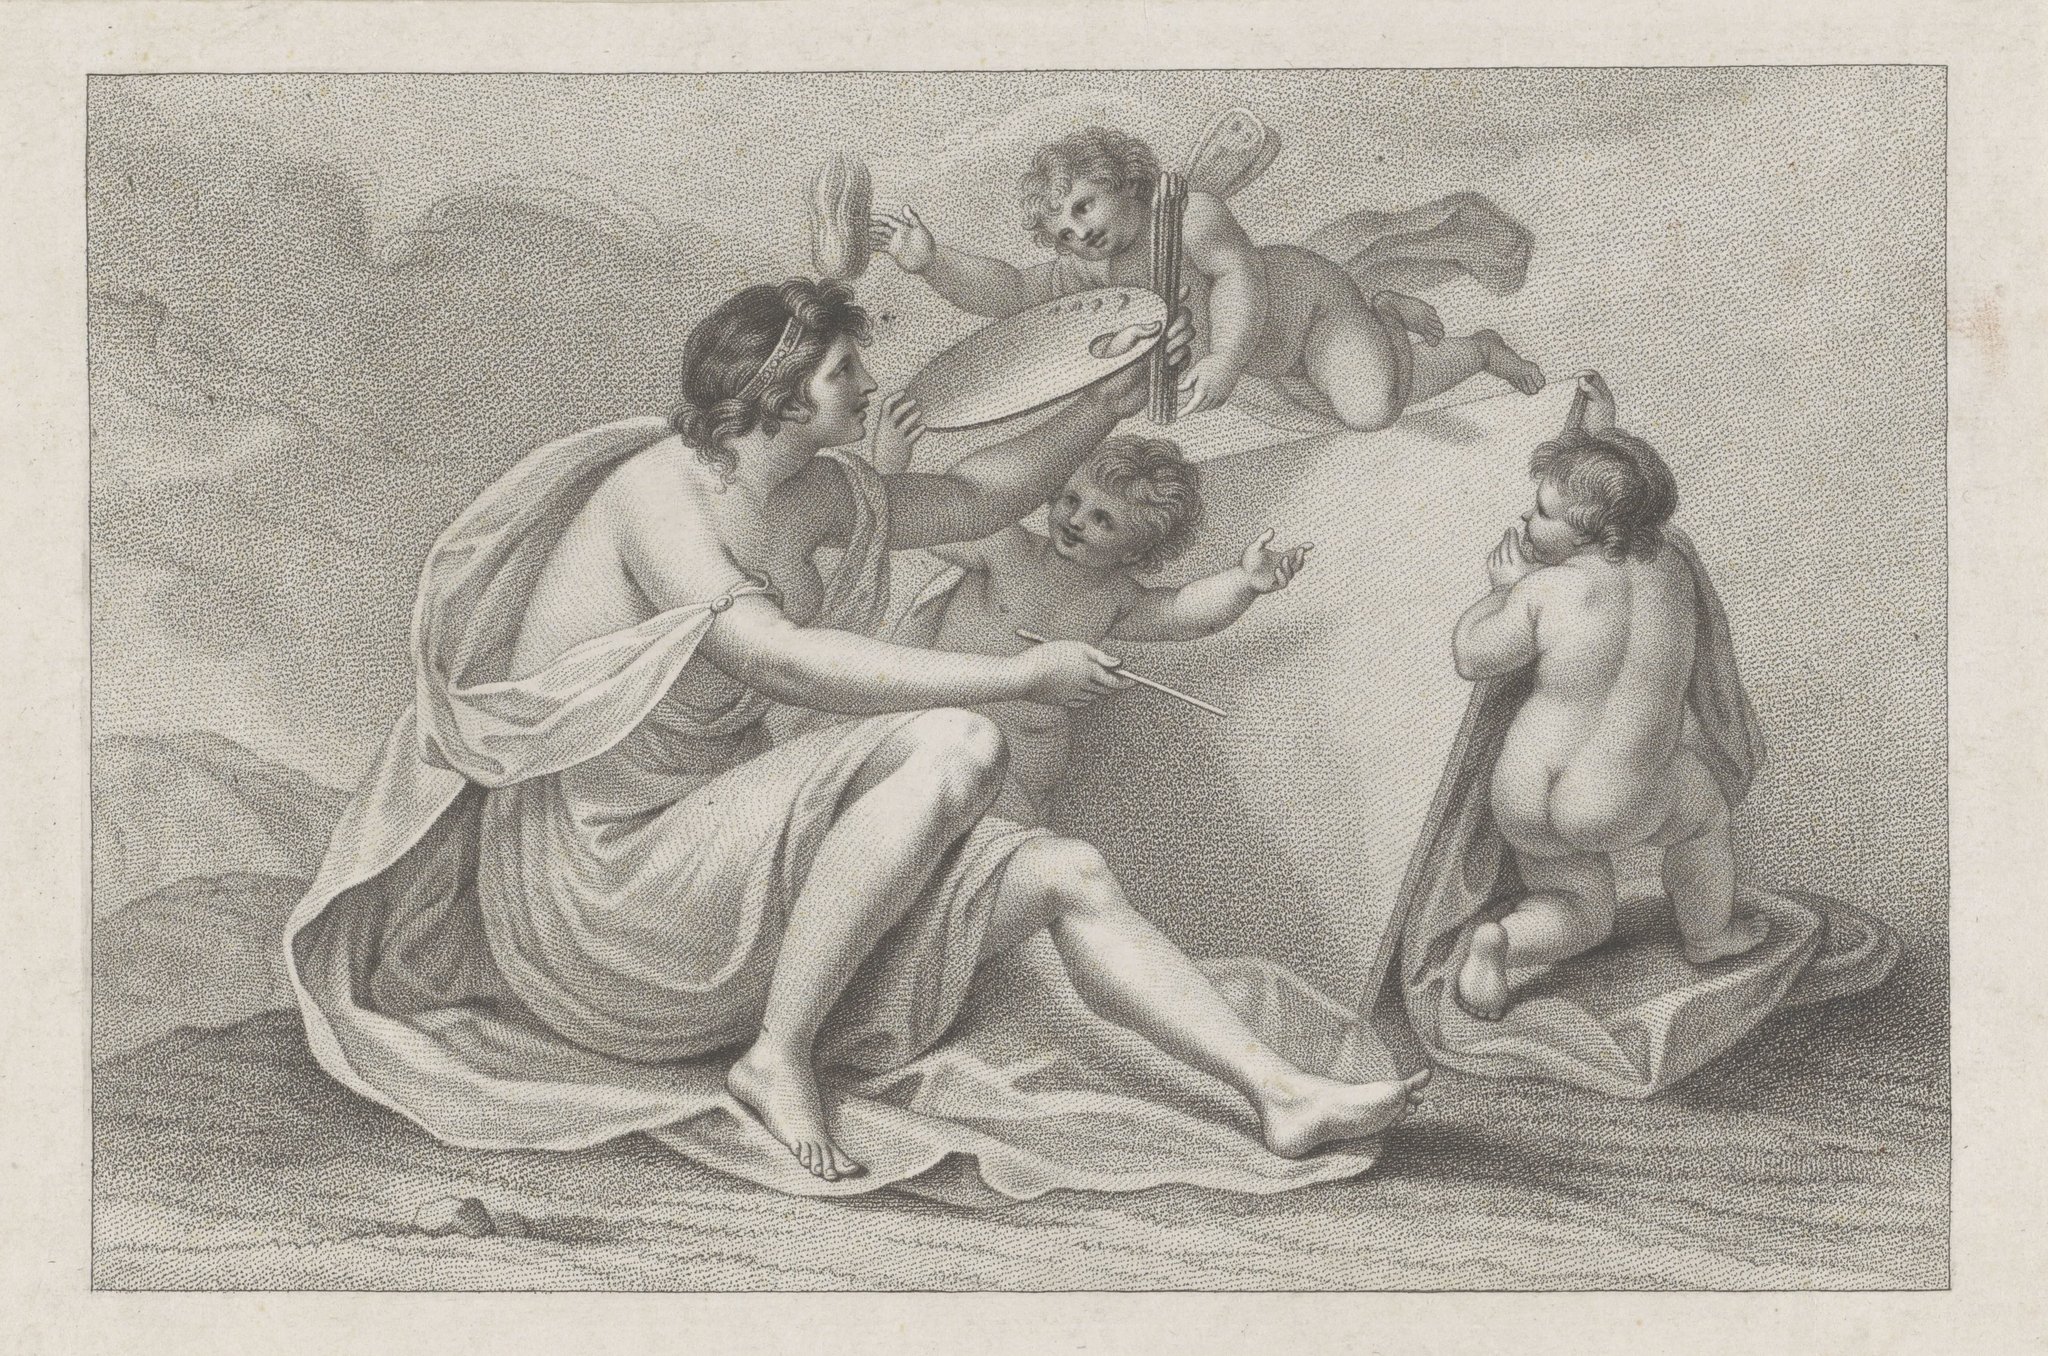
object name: print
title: Ciprianis beginselen van het tekenen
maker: francesco bartolozzi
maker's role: draughtsman, print maker, publisher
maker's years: 1727-1815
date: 1738-1815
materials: paper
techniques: etching, engraving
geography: italy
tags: drawing, art, single muses, cupids: 'amores', 'amoretti', 'putti'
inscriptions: collector's mark: Lugt 2228, collector's mark: Lugt 2760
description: Een Muse of de personificatie van de schilderkunst zit voor een leeg tablet. Om het tablet staan en zweven drie putti.